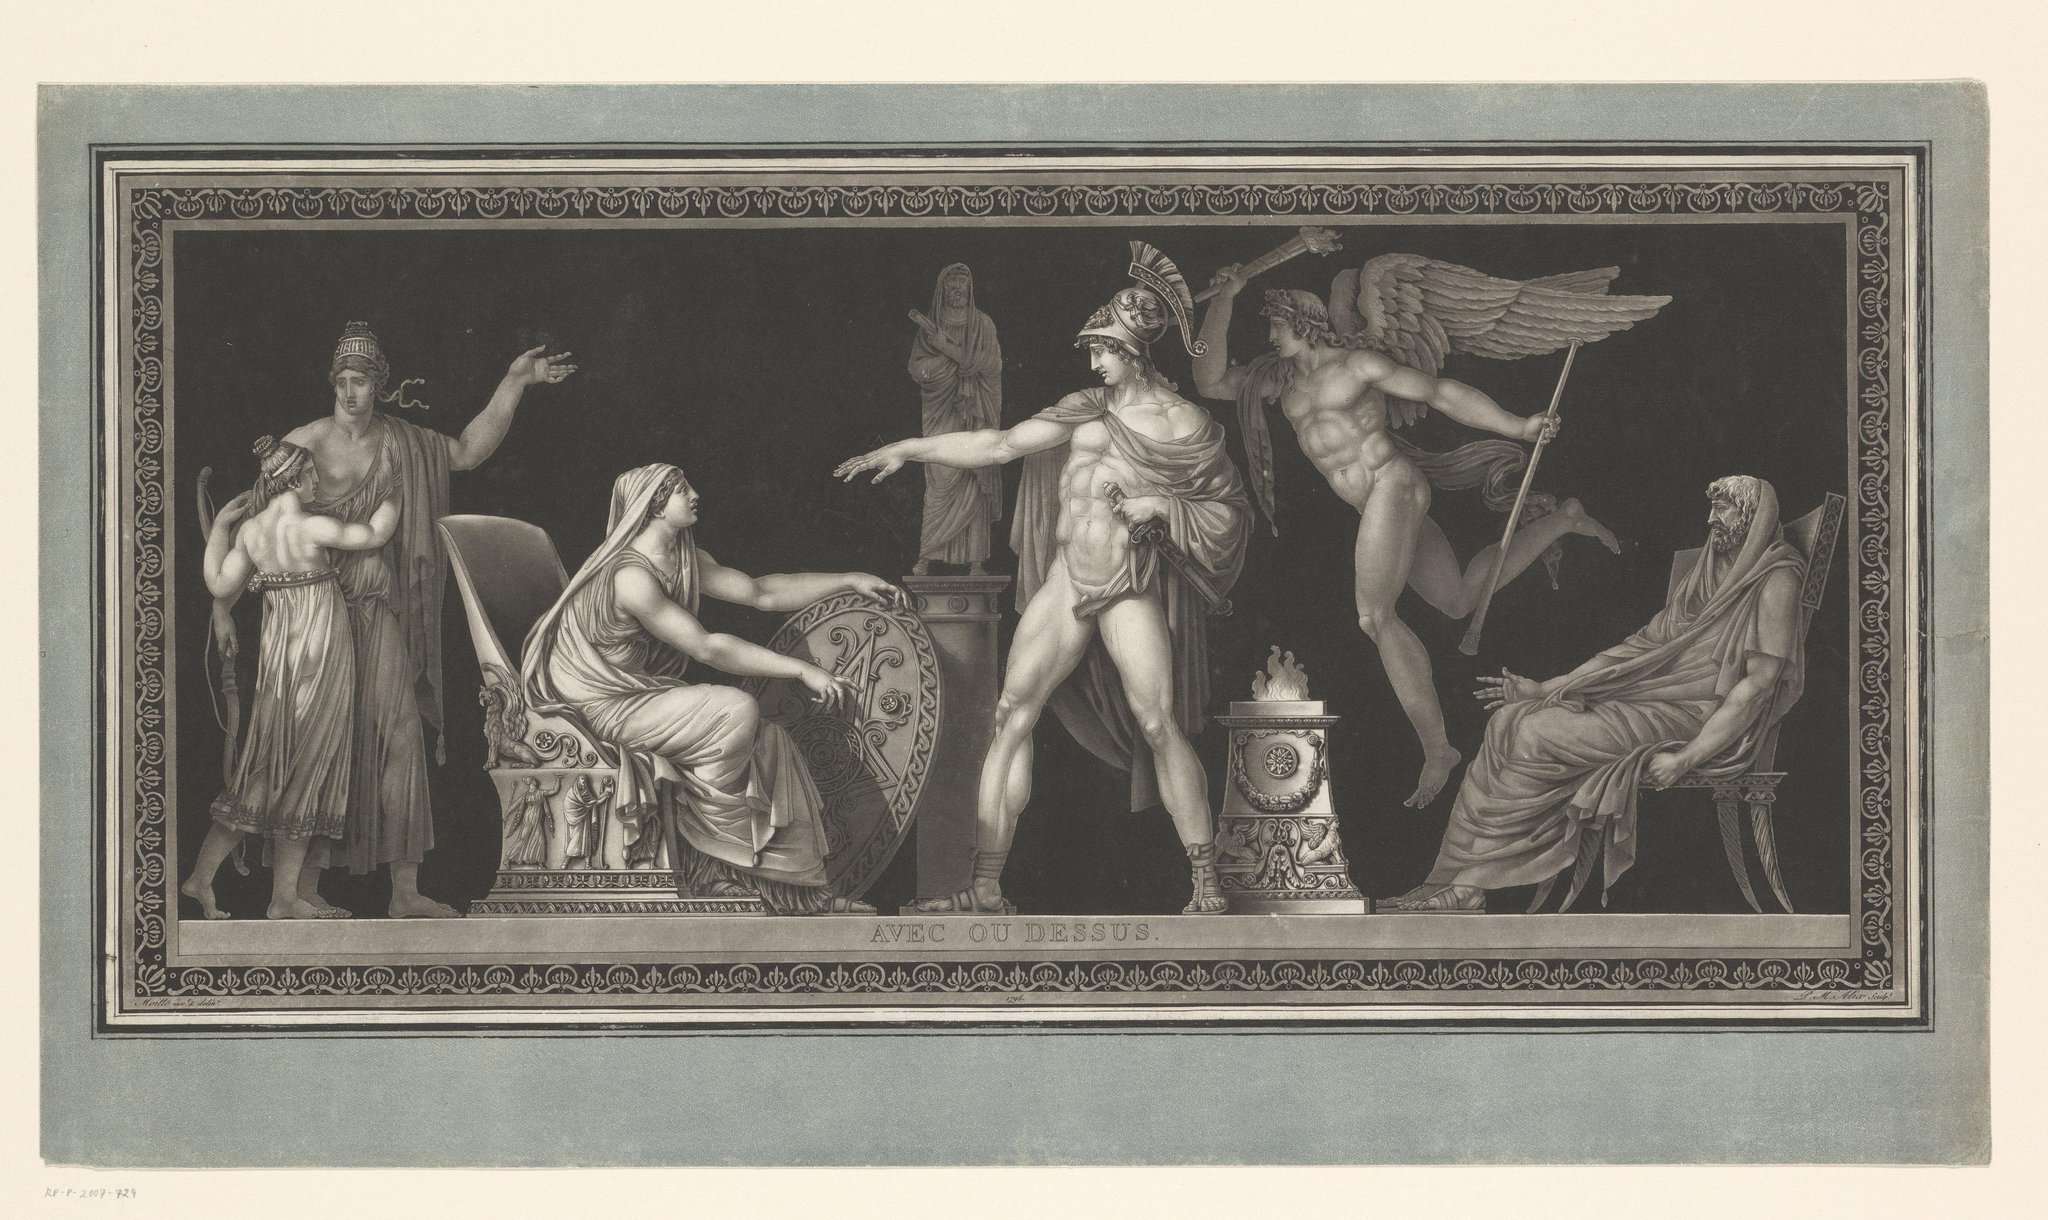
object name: print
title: Afscheid tussen een Spartaanse vrouw en haar zoon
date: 1795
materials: paper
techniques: aquatint, engraving, etching, roulette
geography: france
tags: (story of) the women of sparta, taking leave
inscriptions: collector's mark: Lugt 2760, collector's mark: Lugt 2228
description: In het midden staat de zoon met helm en dolk, achter hem een gevleugelde genus met toorts en bazuin. Links van hem zit zijn moeder die hem een schild aanreikt. Uiterst links een vrouw met een meisje en uiterst rechts een zittende oude man. Onder de afbeelding de titel.